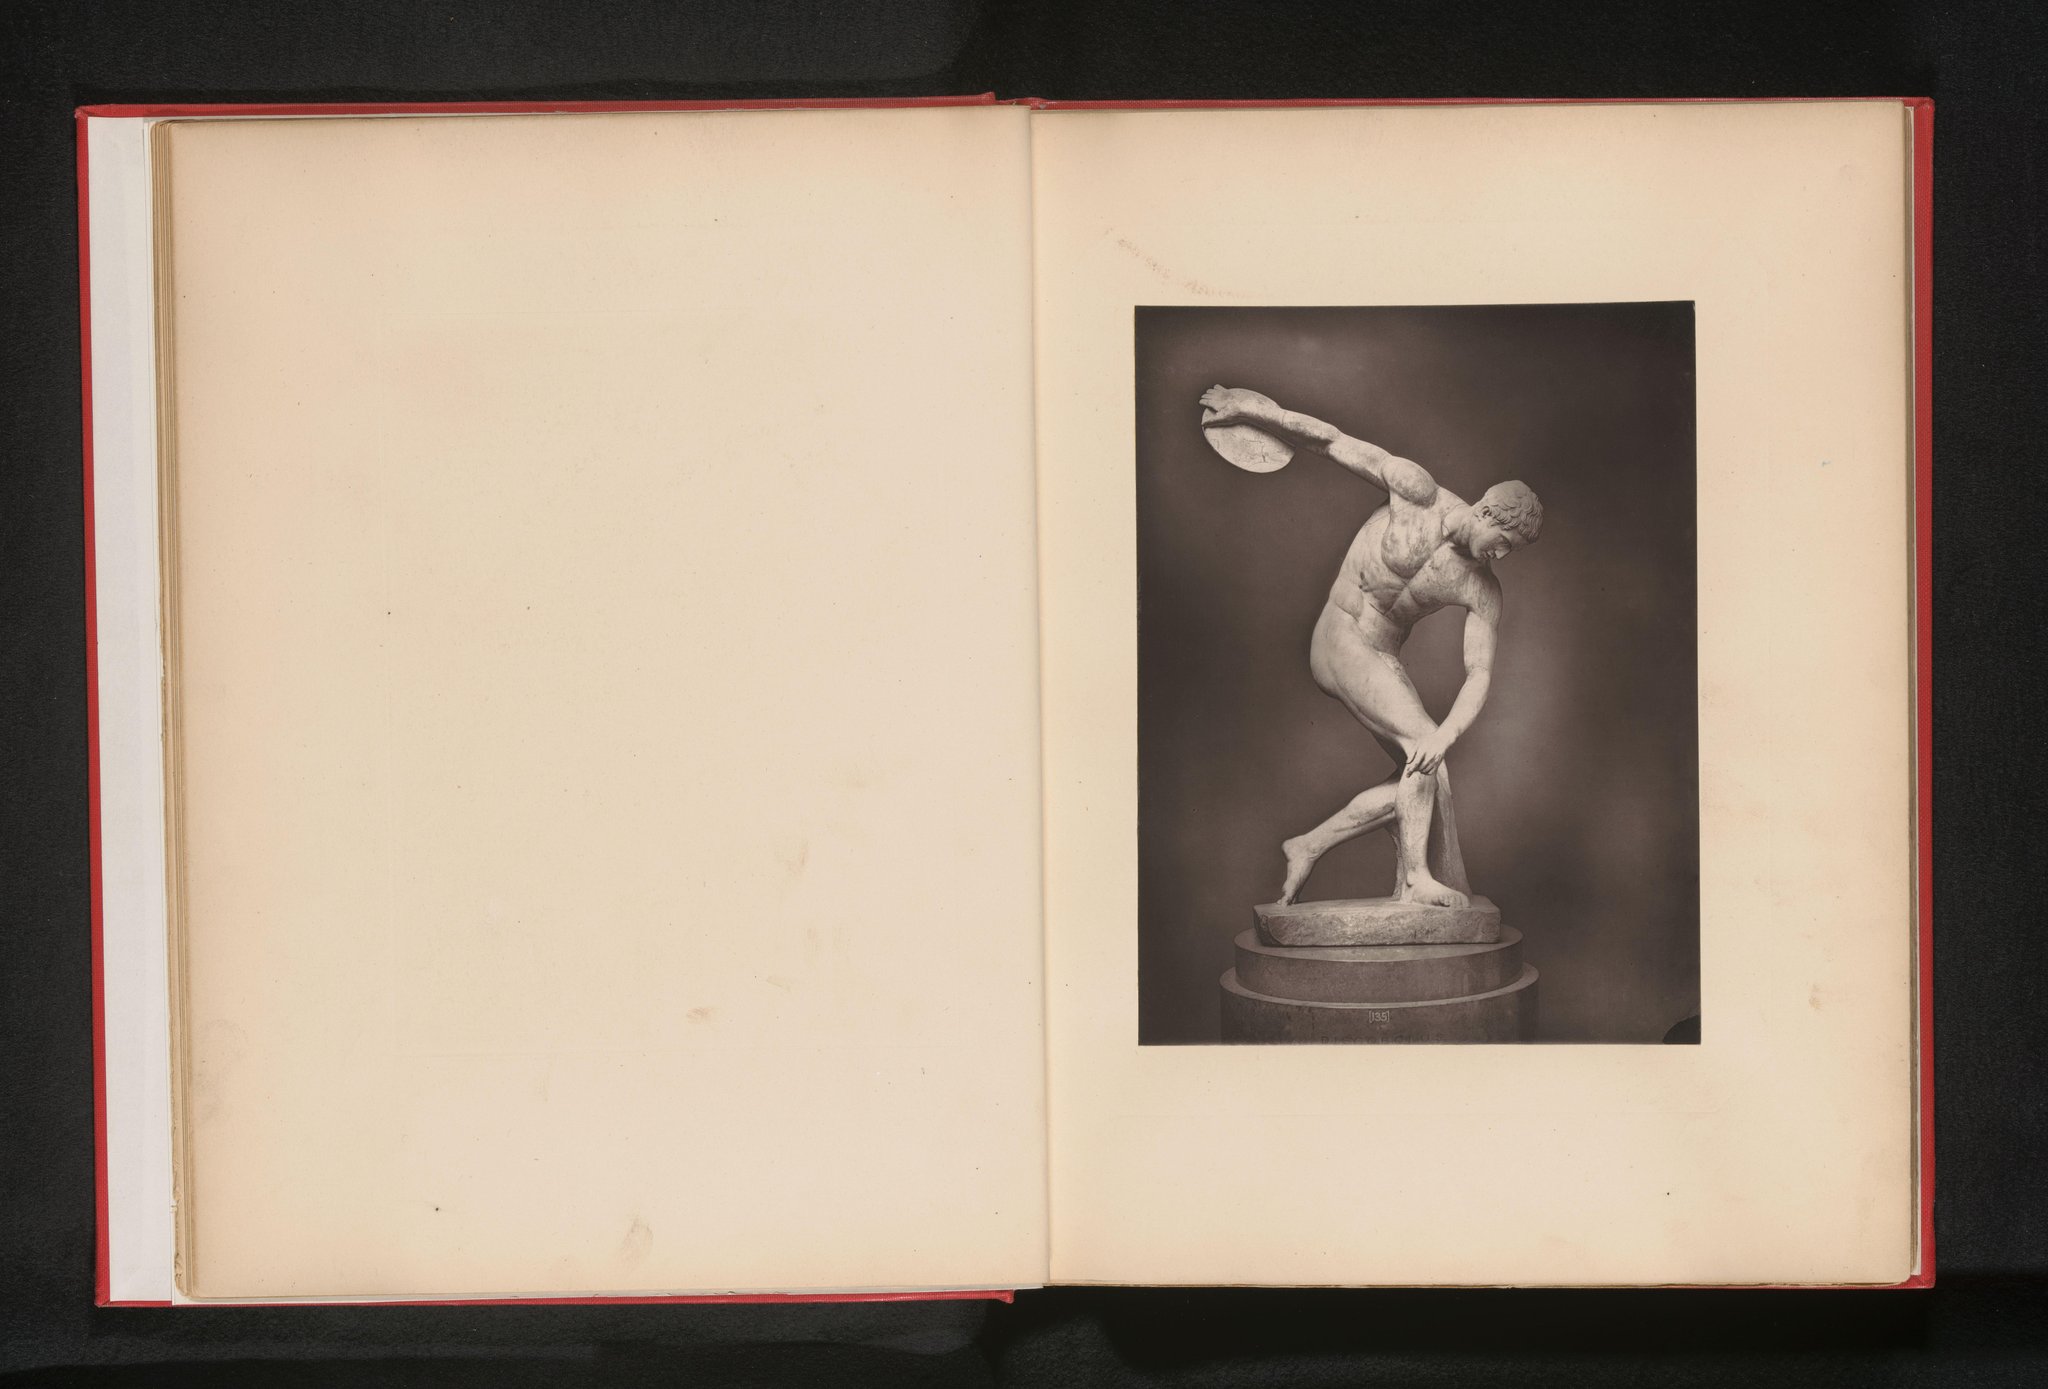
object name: page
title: Standbeeld van de discuswerper door Myron van Eleutherae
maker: stephen thompson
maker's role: fotograaf, schrijver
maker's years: 1831-1893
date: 1873-1878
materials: paper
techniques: woodburytype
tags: discus-throwing, sculpture